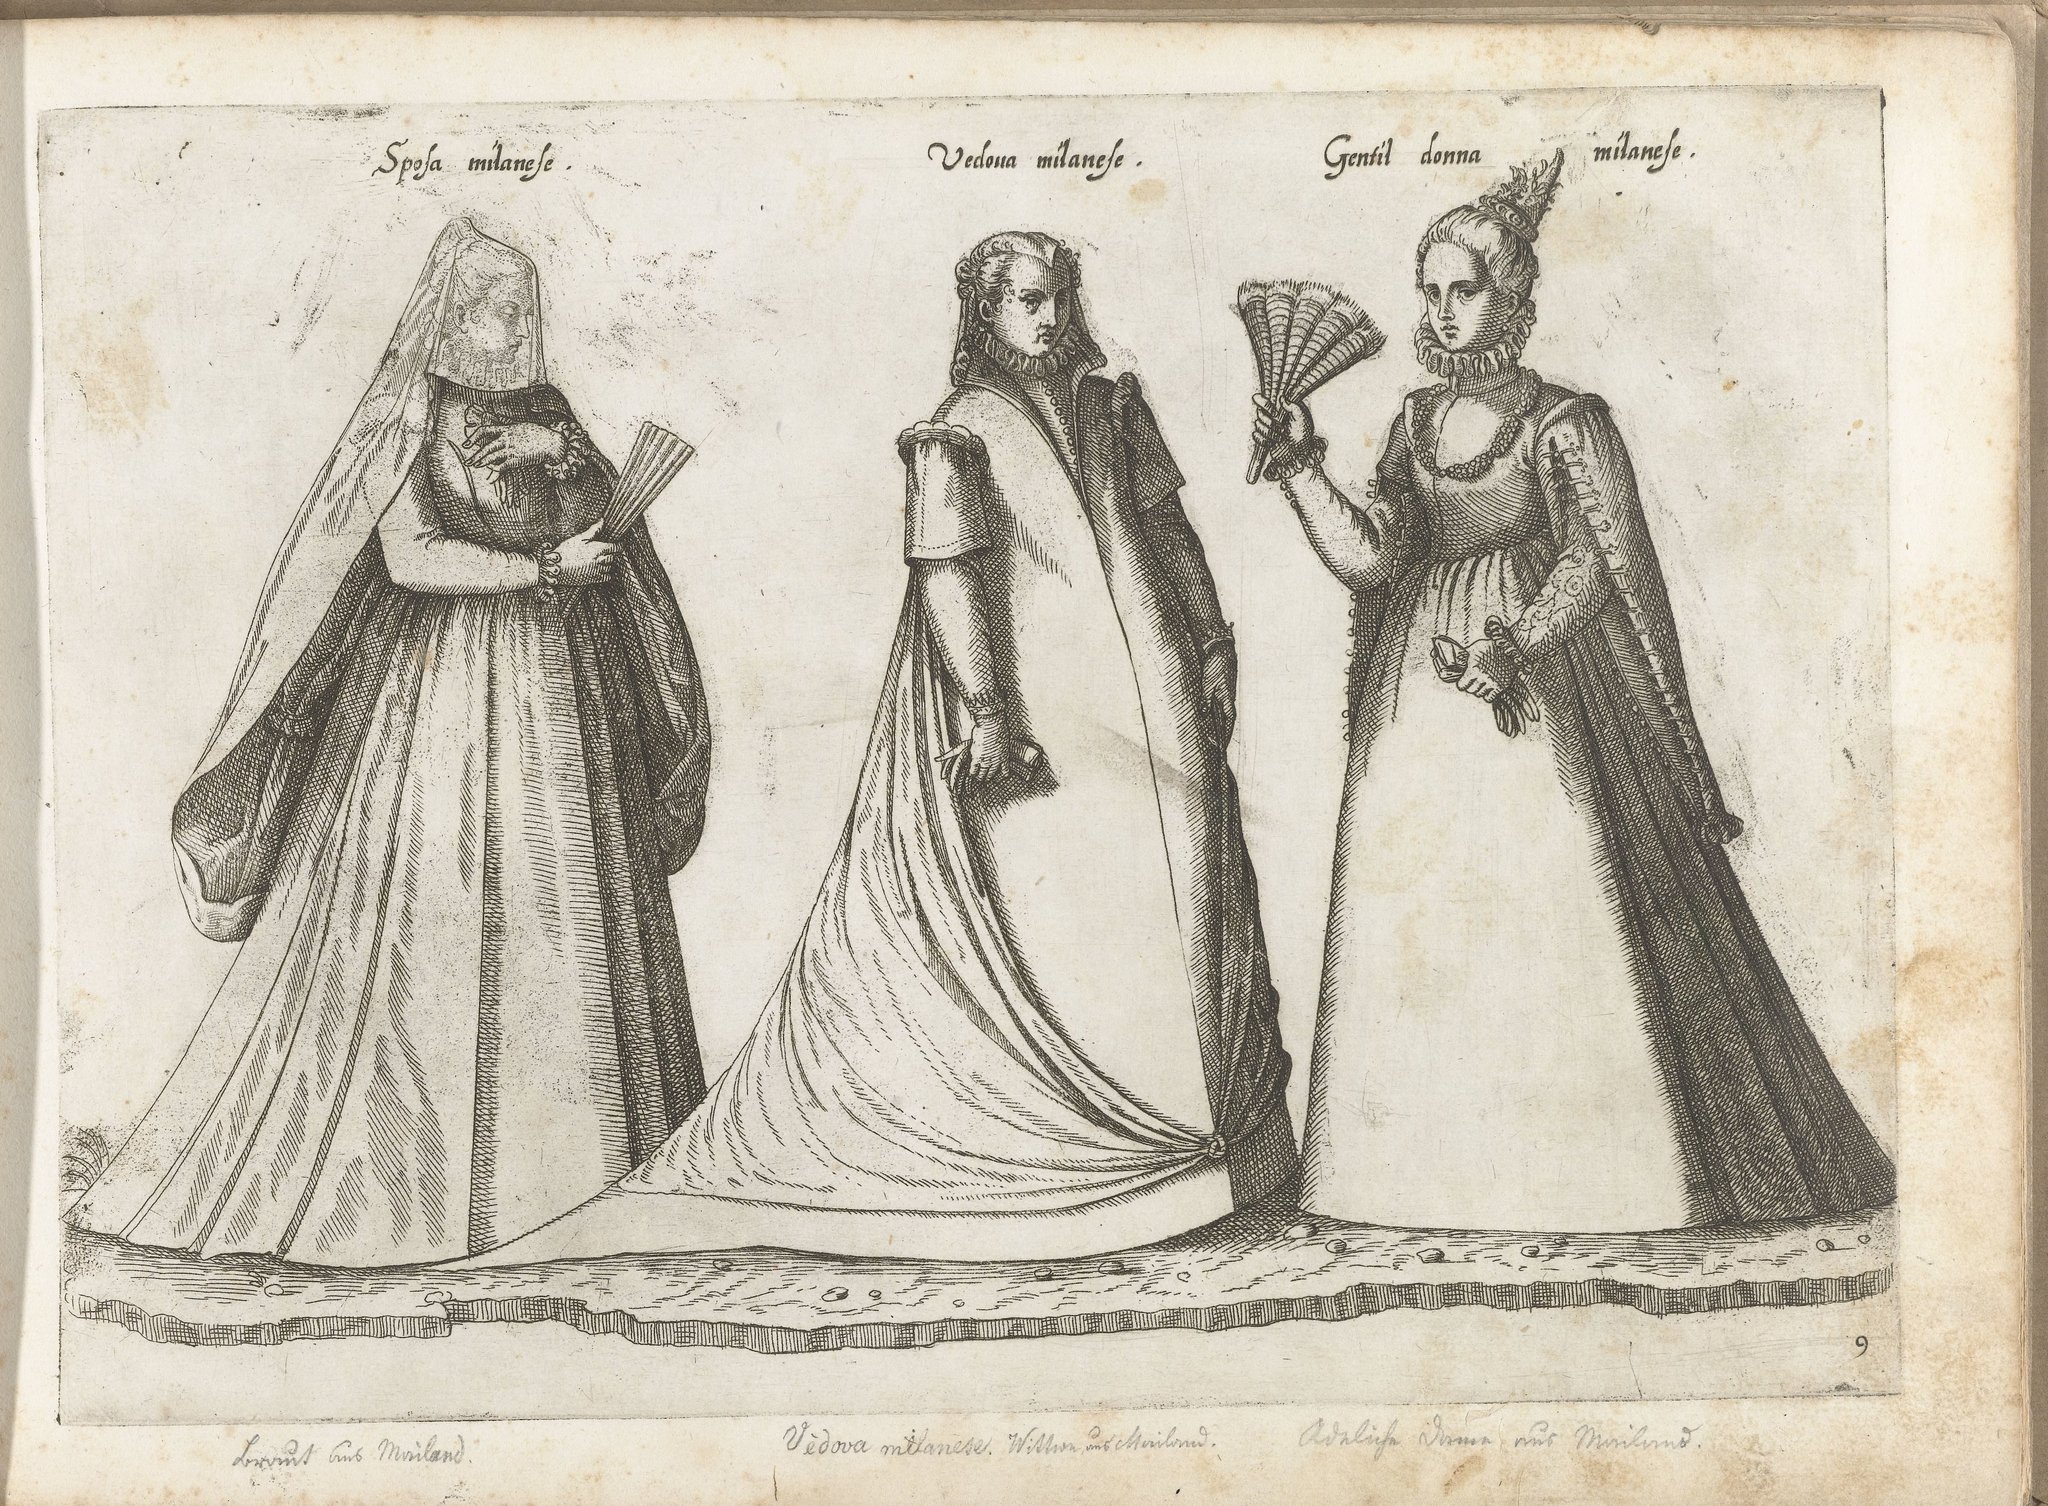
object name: costume print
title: Drie vrouwen, gekleed volgens de Milanese mode ca. 1580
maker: bartolomeo grassi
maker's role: publisher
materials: paper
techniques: engraving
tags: fan, widow, europeans (with name) (+ costume), veil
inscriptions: number: ‘8’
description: Links een getrouwde vrouw uit Milaan, het gezecht bedekt met een doorzichtige sluier, gesloten waaier in de linkerhand. In het midden een weduwe en rechts een jongedame met een veren waaier in de rechter- handschoenen in de linkerhand. Prent nr. 9 uit album 'Dei veri ritratti degl'habiti di tvtte le parti del mondo intagliati in rame per opra di Bartolomeo Grassi', 1585.